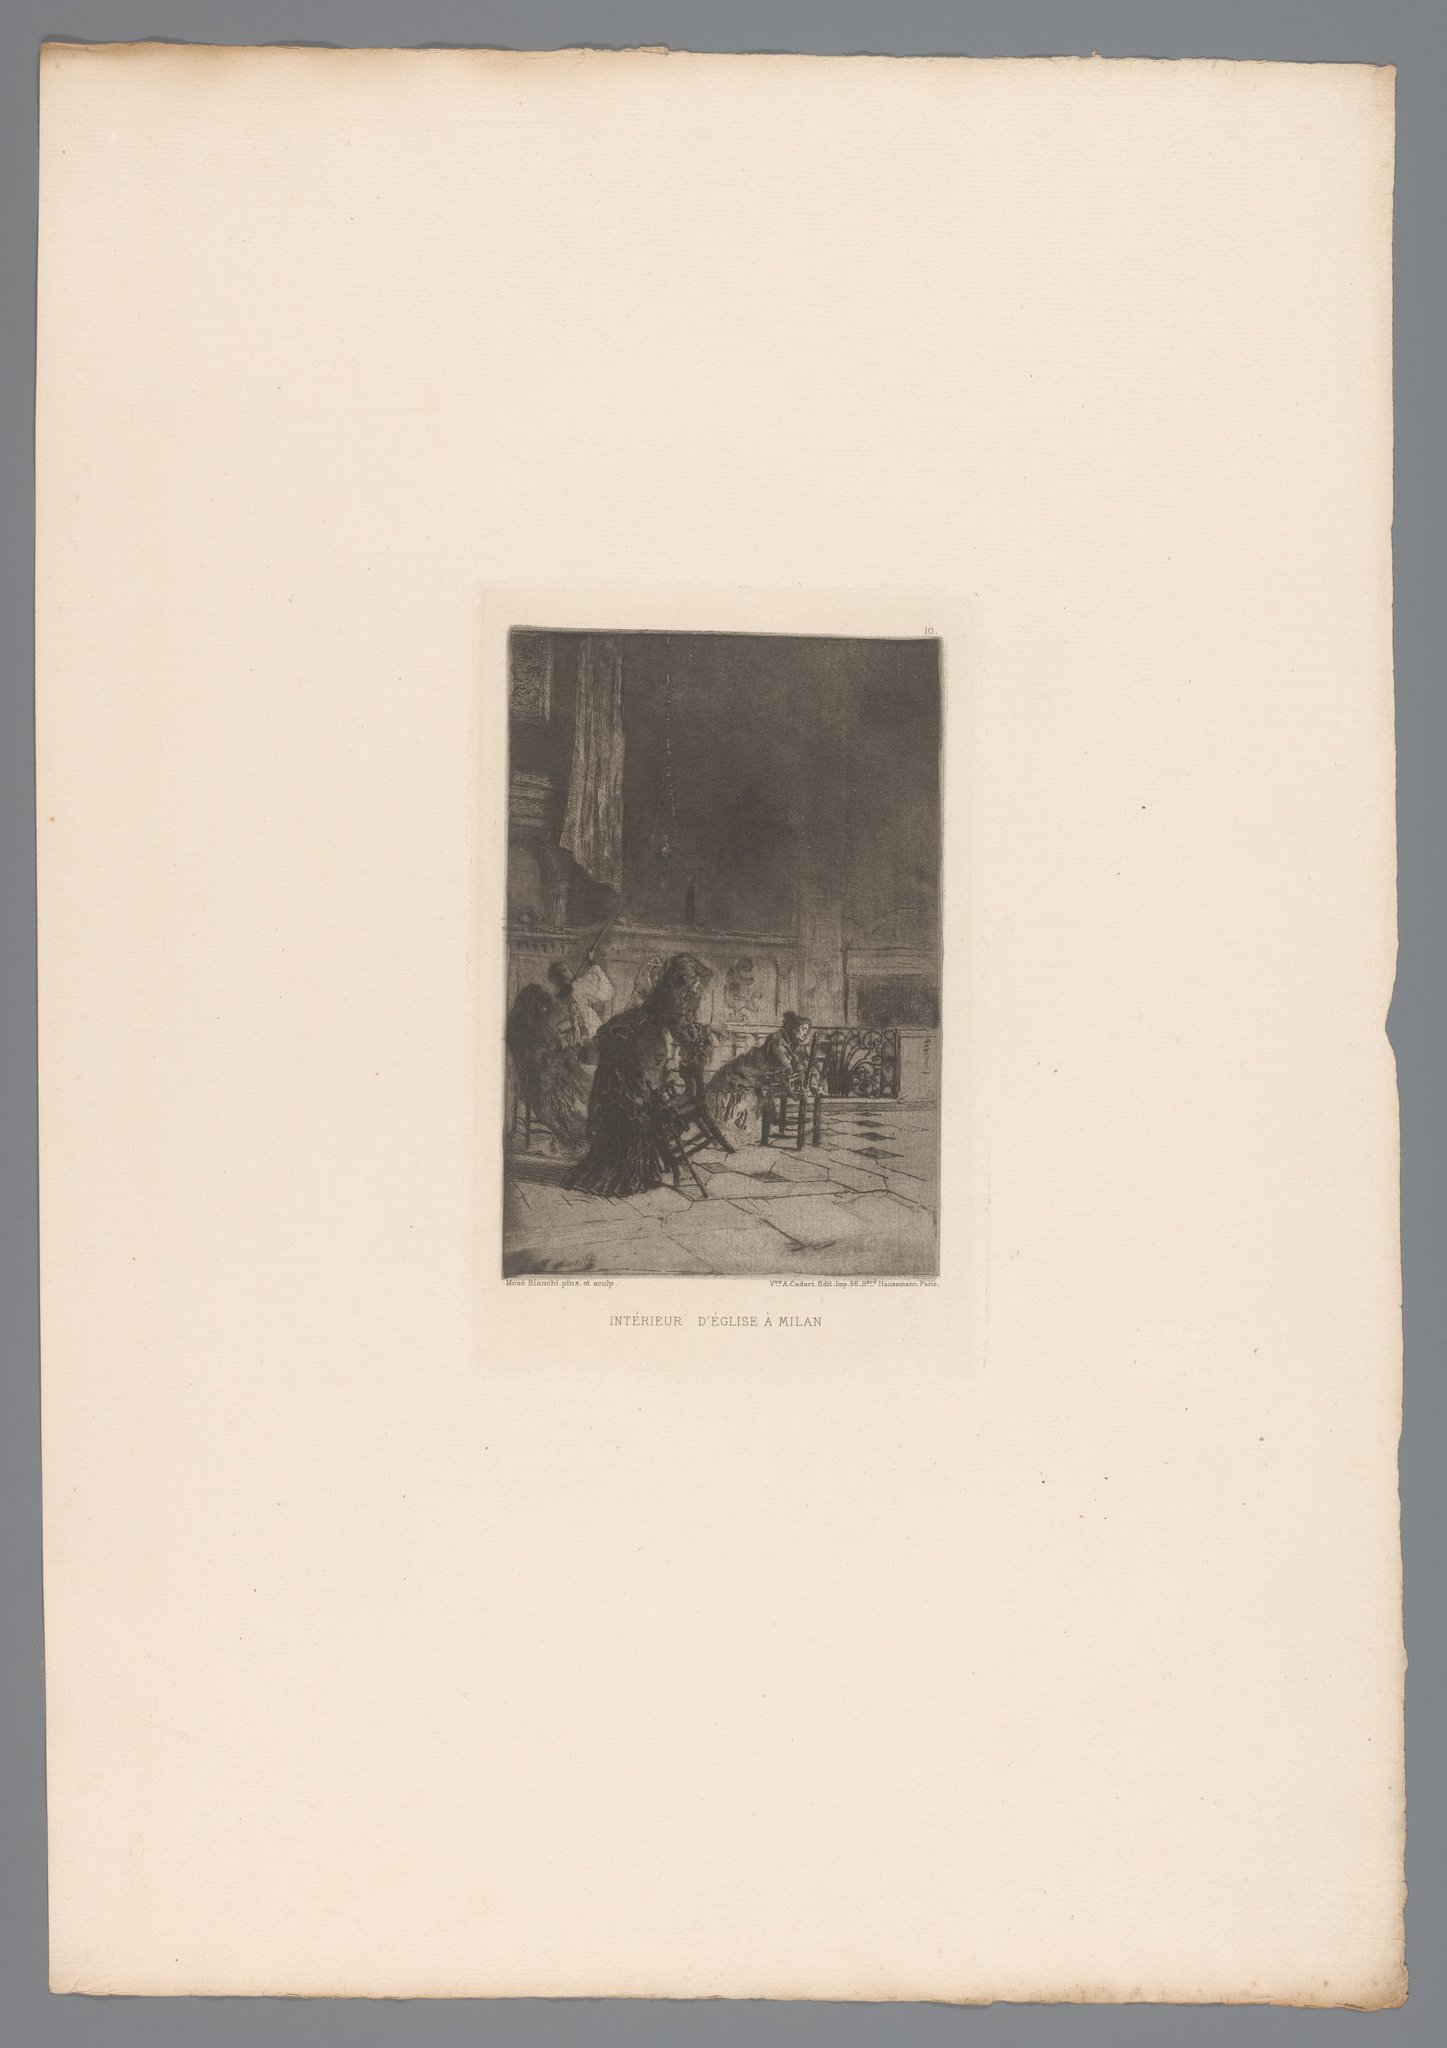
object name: print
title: L'eau-forte en 1880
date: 1880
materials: paper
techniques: drypoint, etching, intaglio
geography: paris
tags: interior of church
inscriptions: collector's mark: Lugt 2228, collector's mark: Lugt 2760, collector's mark: ‘AFE v S’, watermark